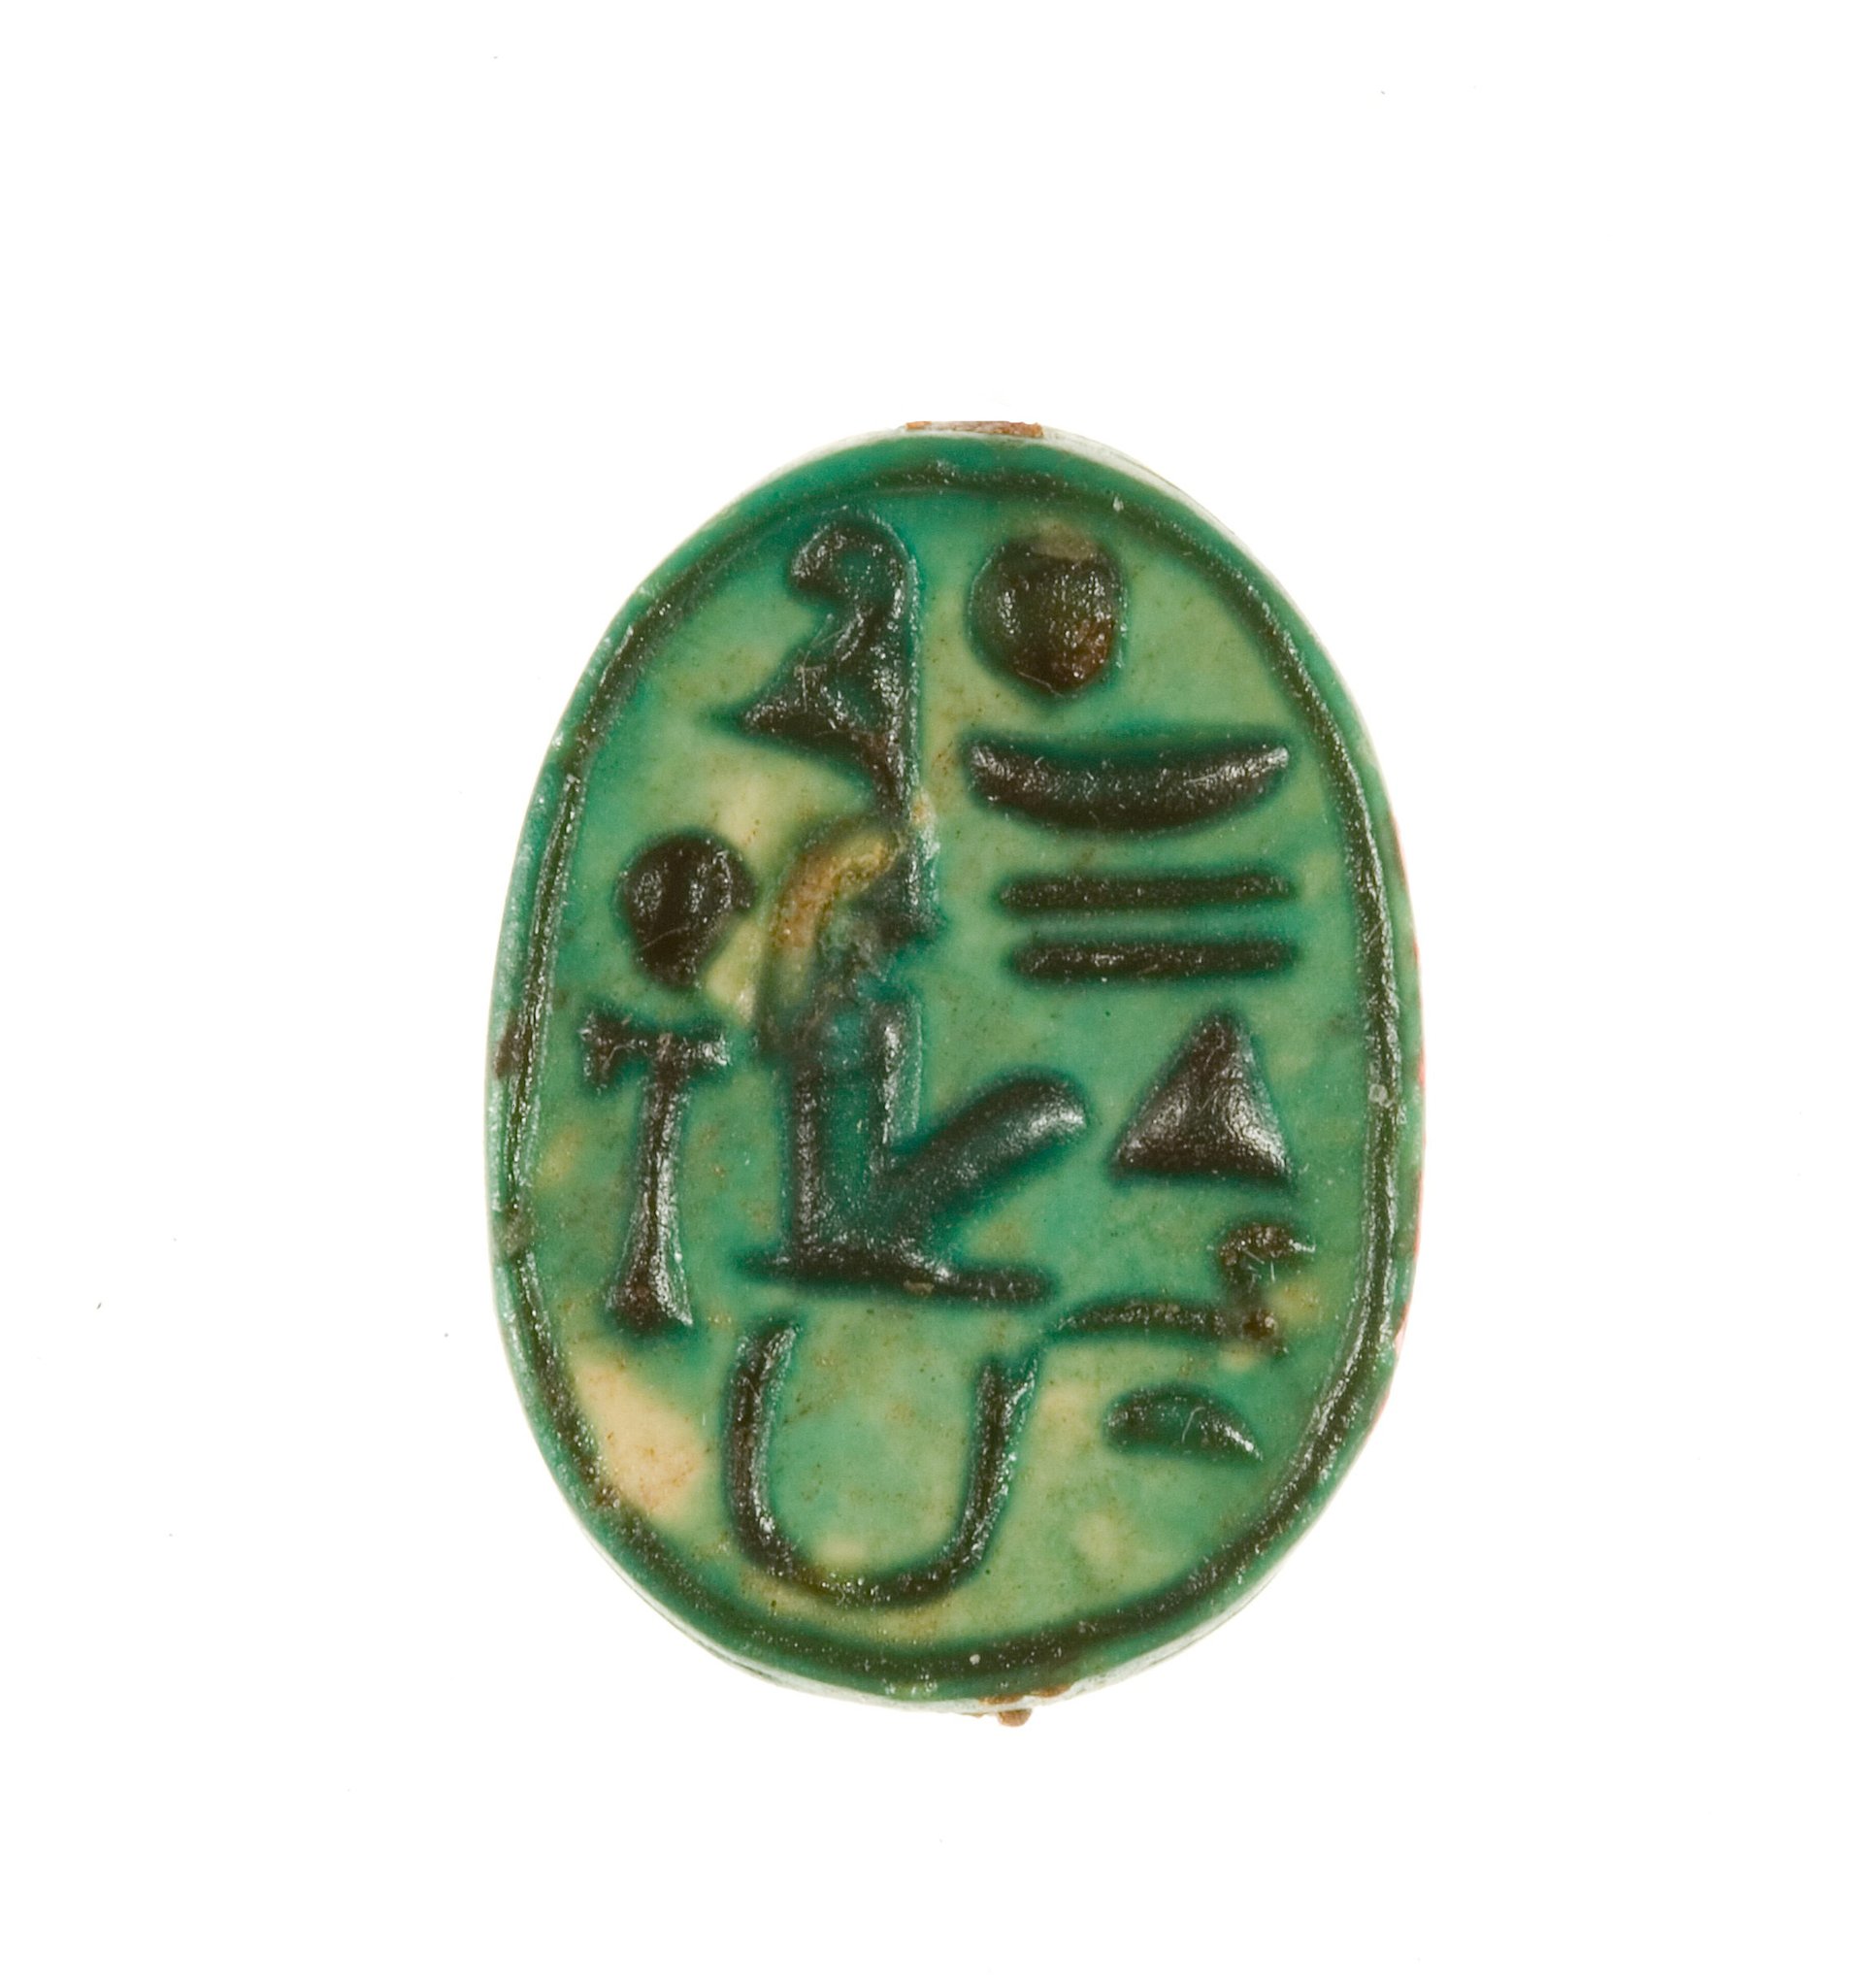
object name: scarab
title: Scarab Inscribed Maatkare (Hatshepsut), Given Life Forever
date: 1479-1458 BCE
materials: stone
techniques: glazing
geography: egypt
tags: scarabs